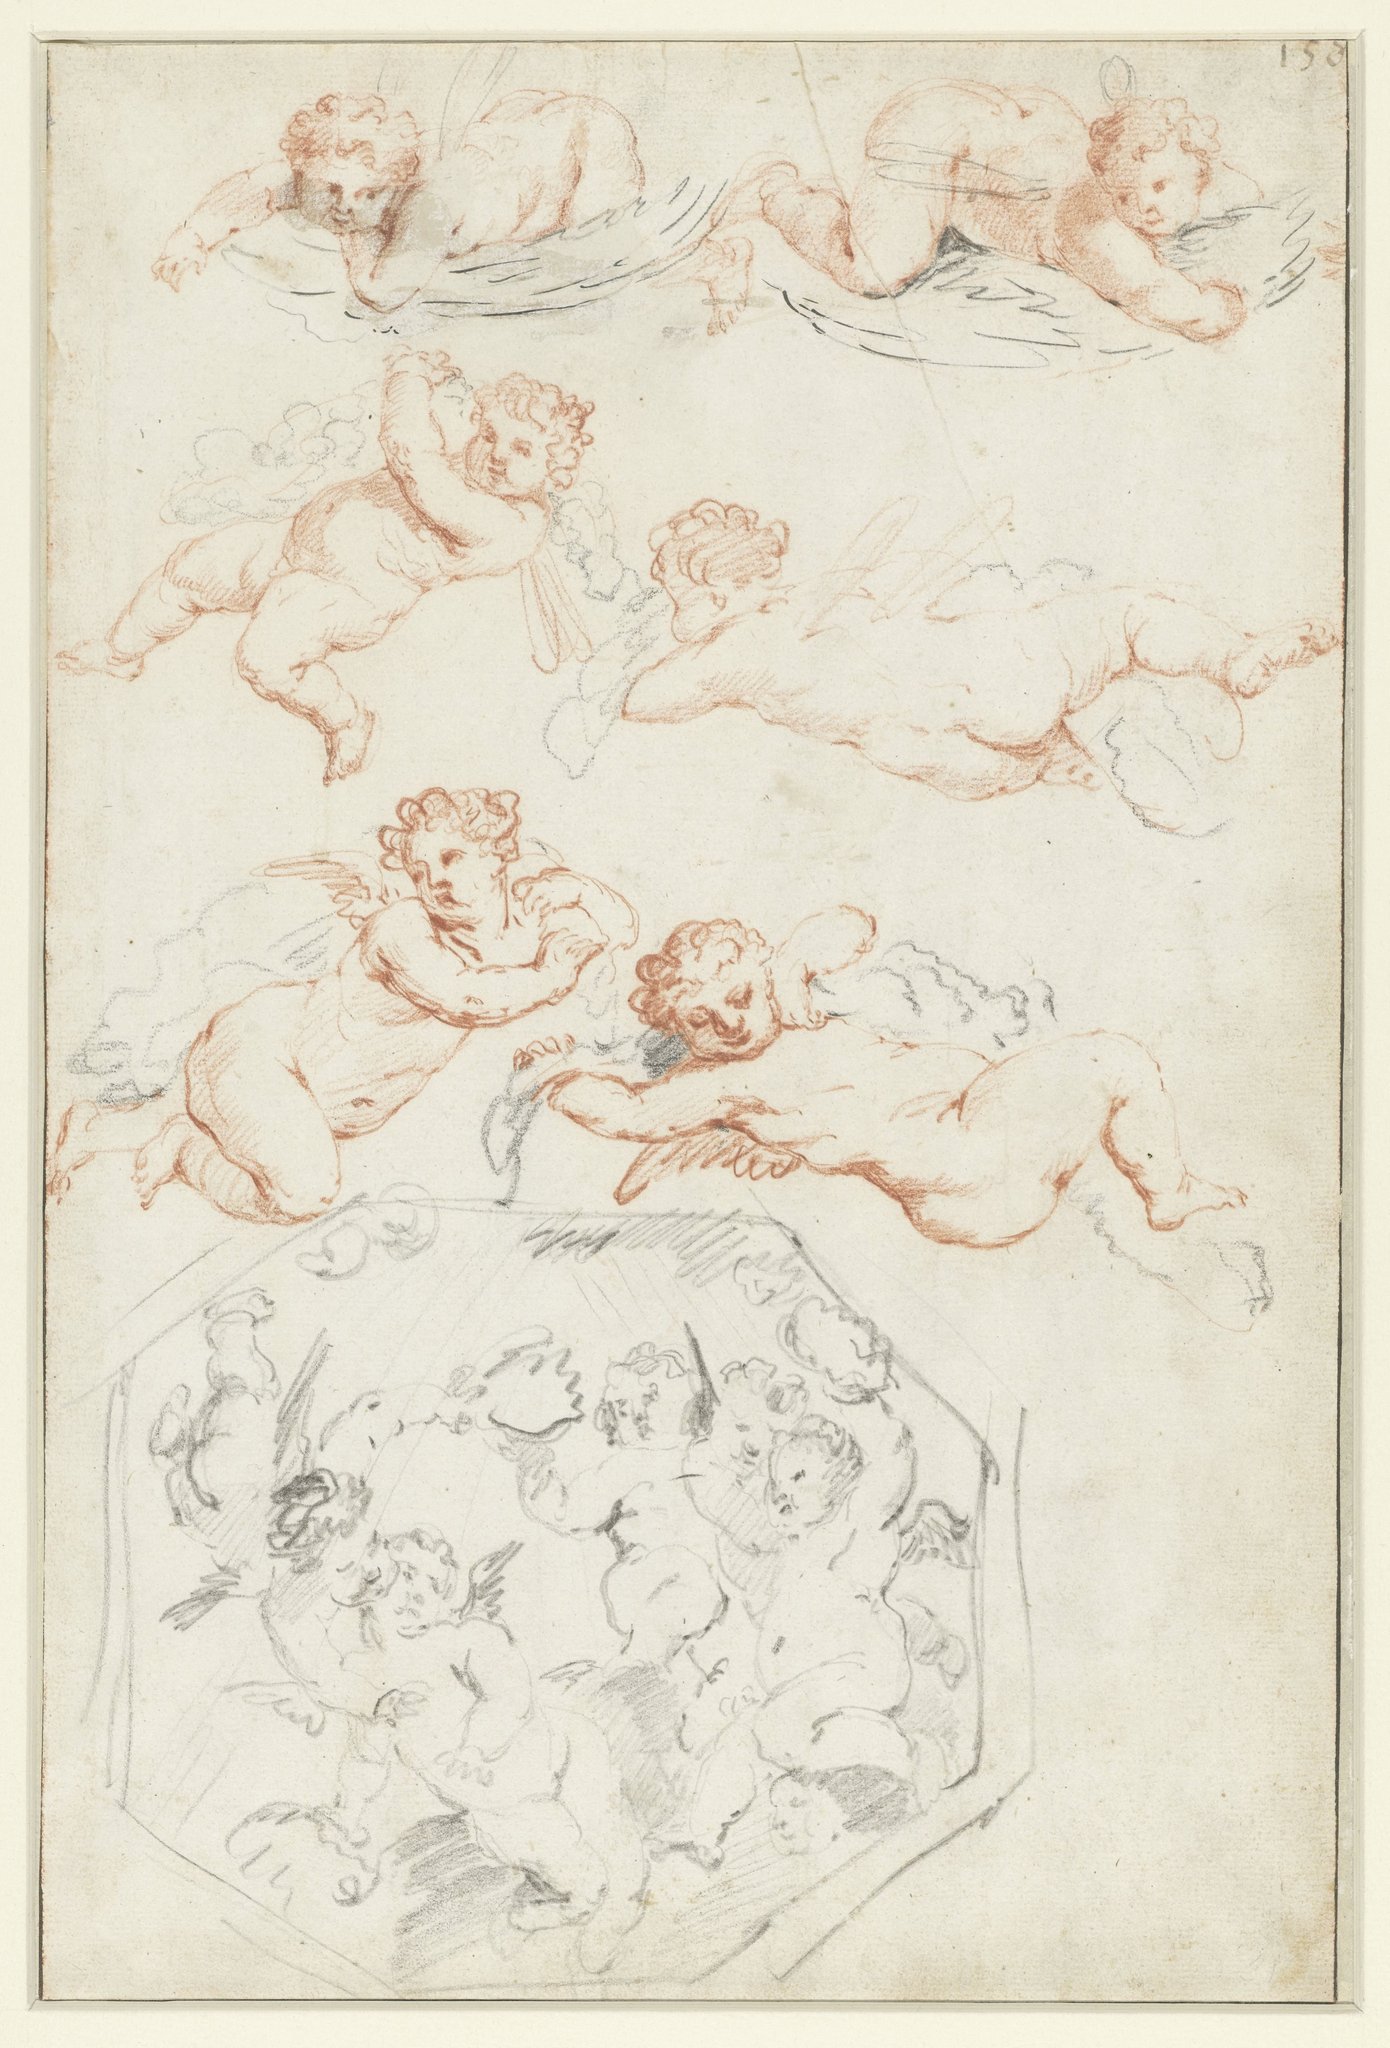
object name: drawing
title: Studies van putti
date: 1700-1800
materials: chalk, ink, paper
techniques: brush, pen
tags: cupids: 'amores', 'amoretti', 'putti'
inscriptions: annotation, verso, lower left, pencil: ‘P. P. Rubens’, annotation, recto, upper right, pen and brown ink: ‘158’, annotation, verso, lower left, pencil: ‘Legaat de Witte / v. Citters’